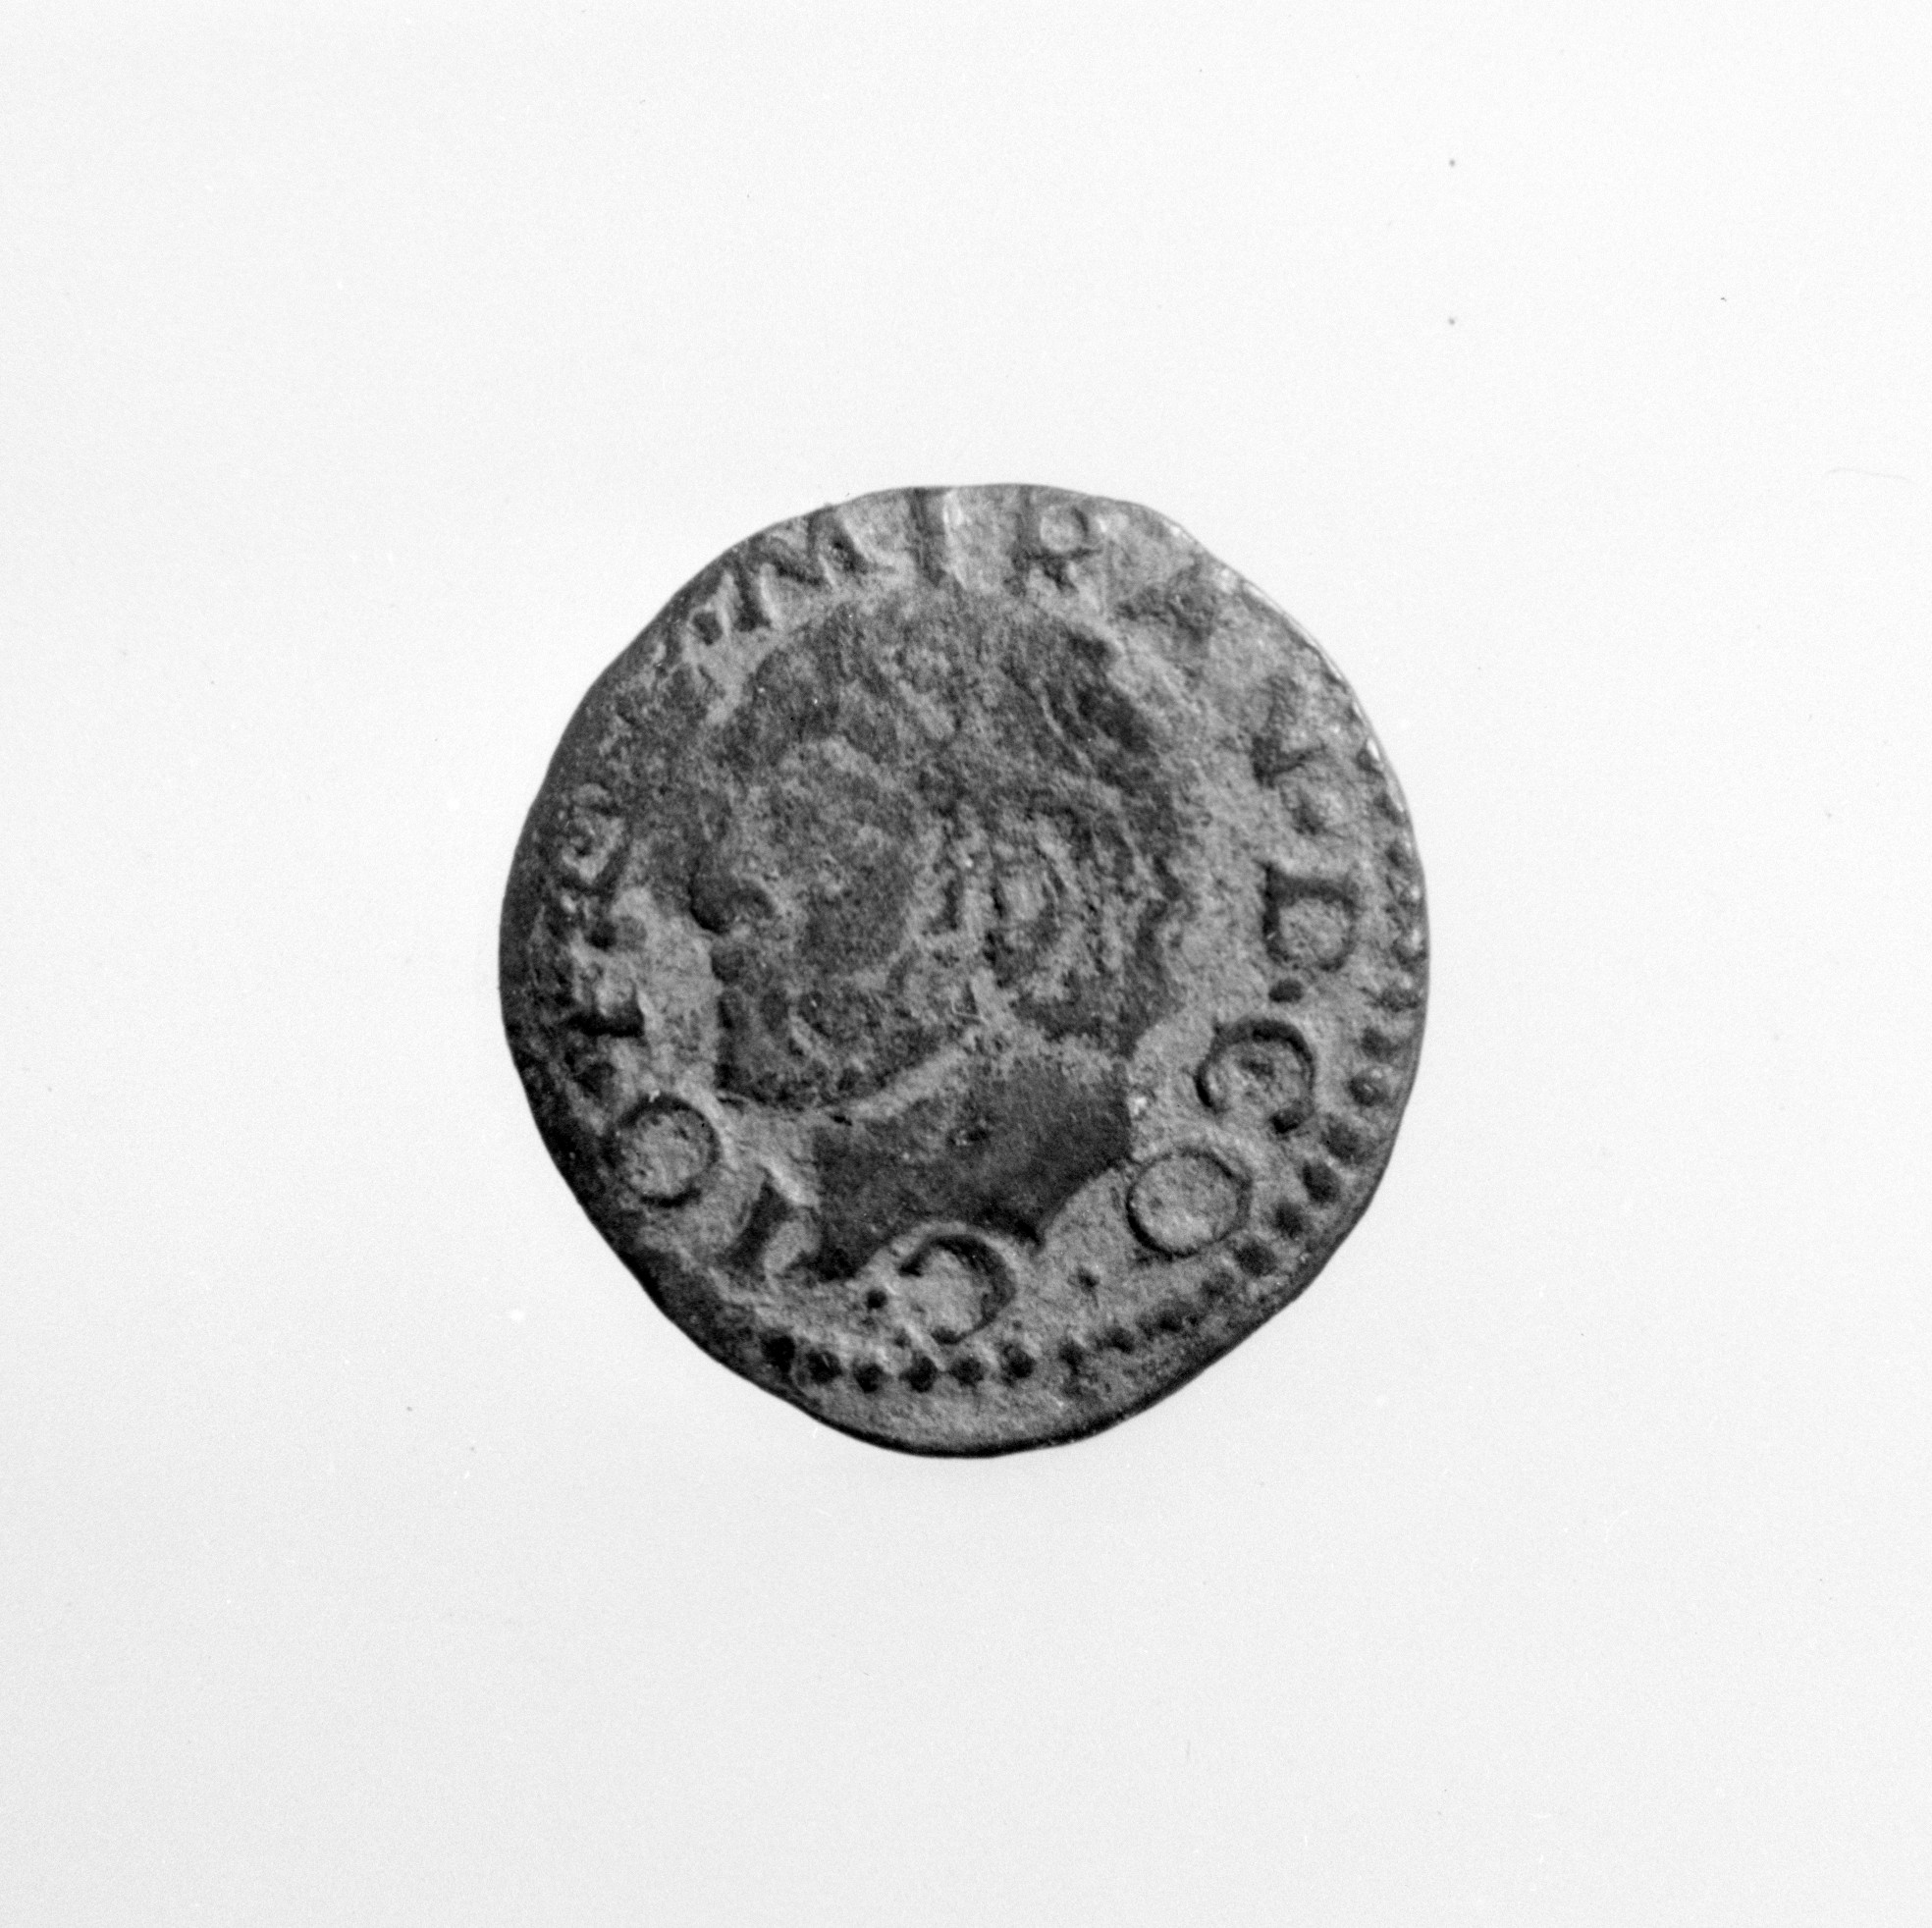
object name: quattrino coin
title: Quattrino coin, Gianfrancesco II di Gonzaga (d. 1519) (?)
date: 1501-1600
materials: bronze